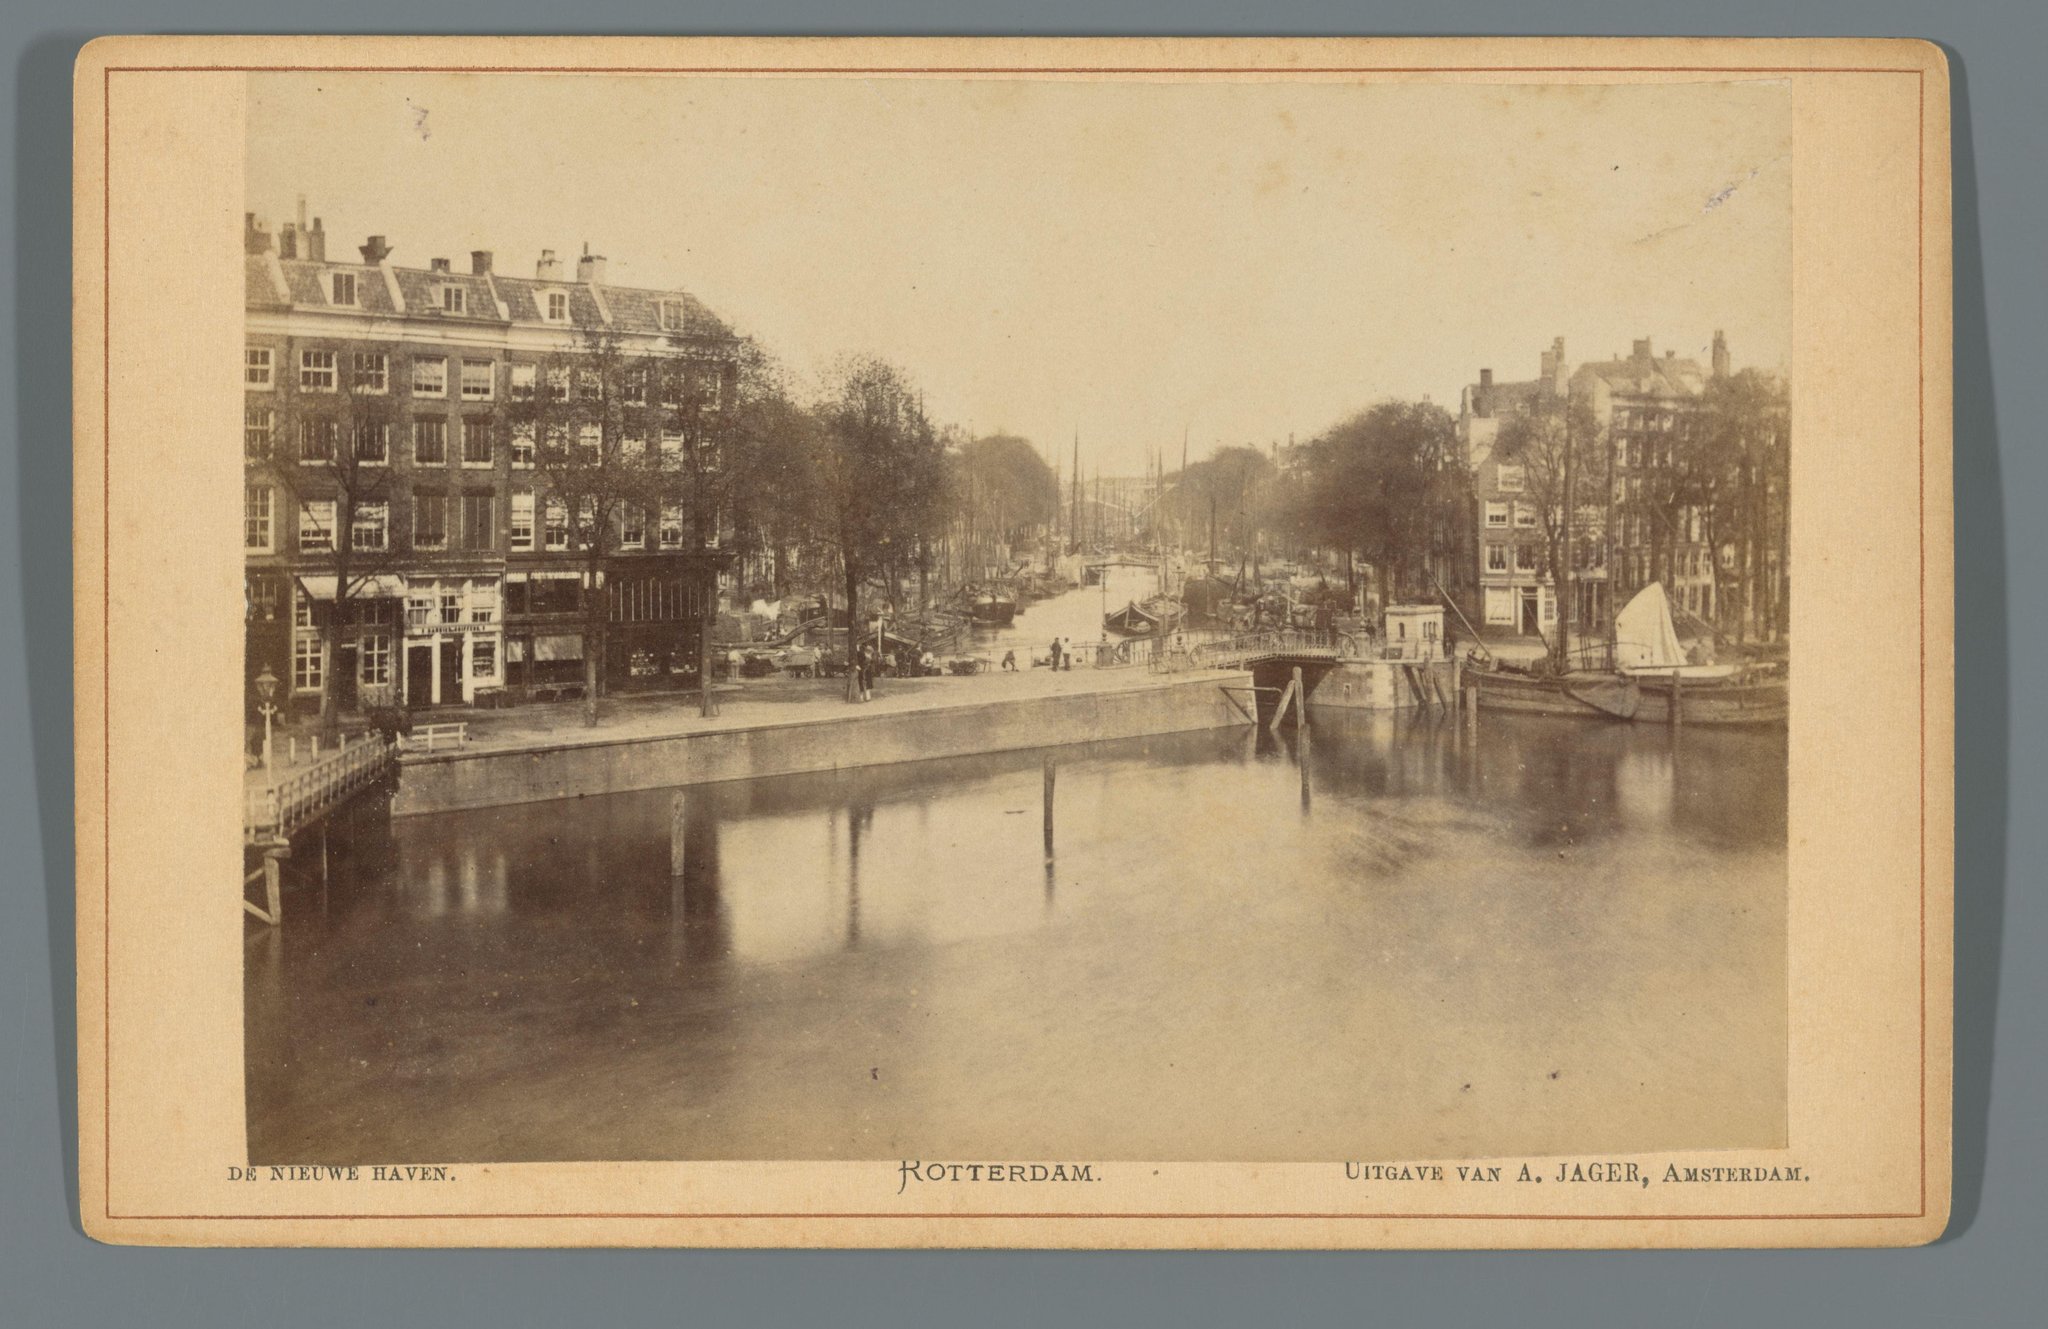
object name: cabinet photograph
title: De Nieuwe Haven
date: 1860-1890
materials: cardboard, photographic support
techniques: albumen print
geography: rotterdam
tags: harbour